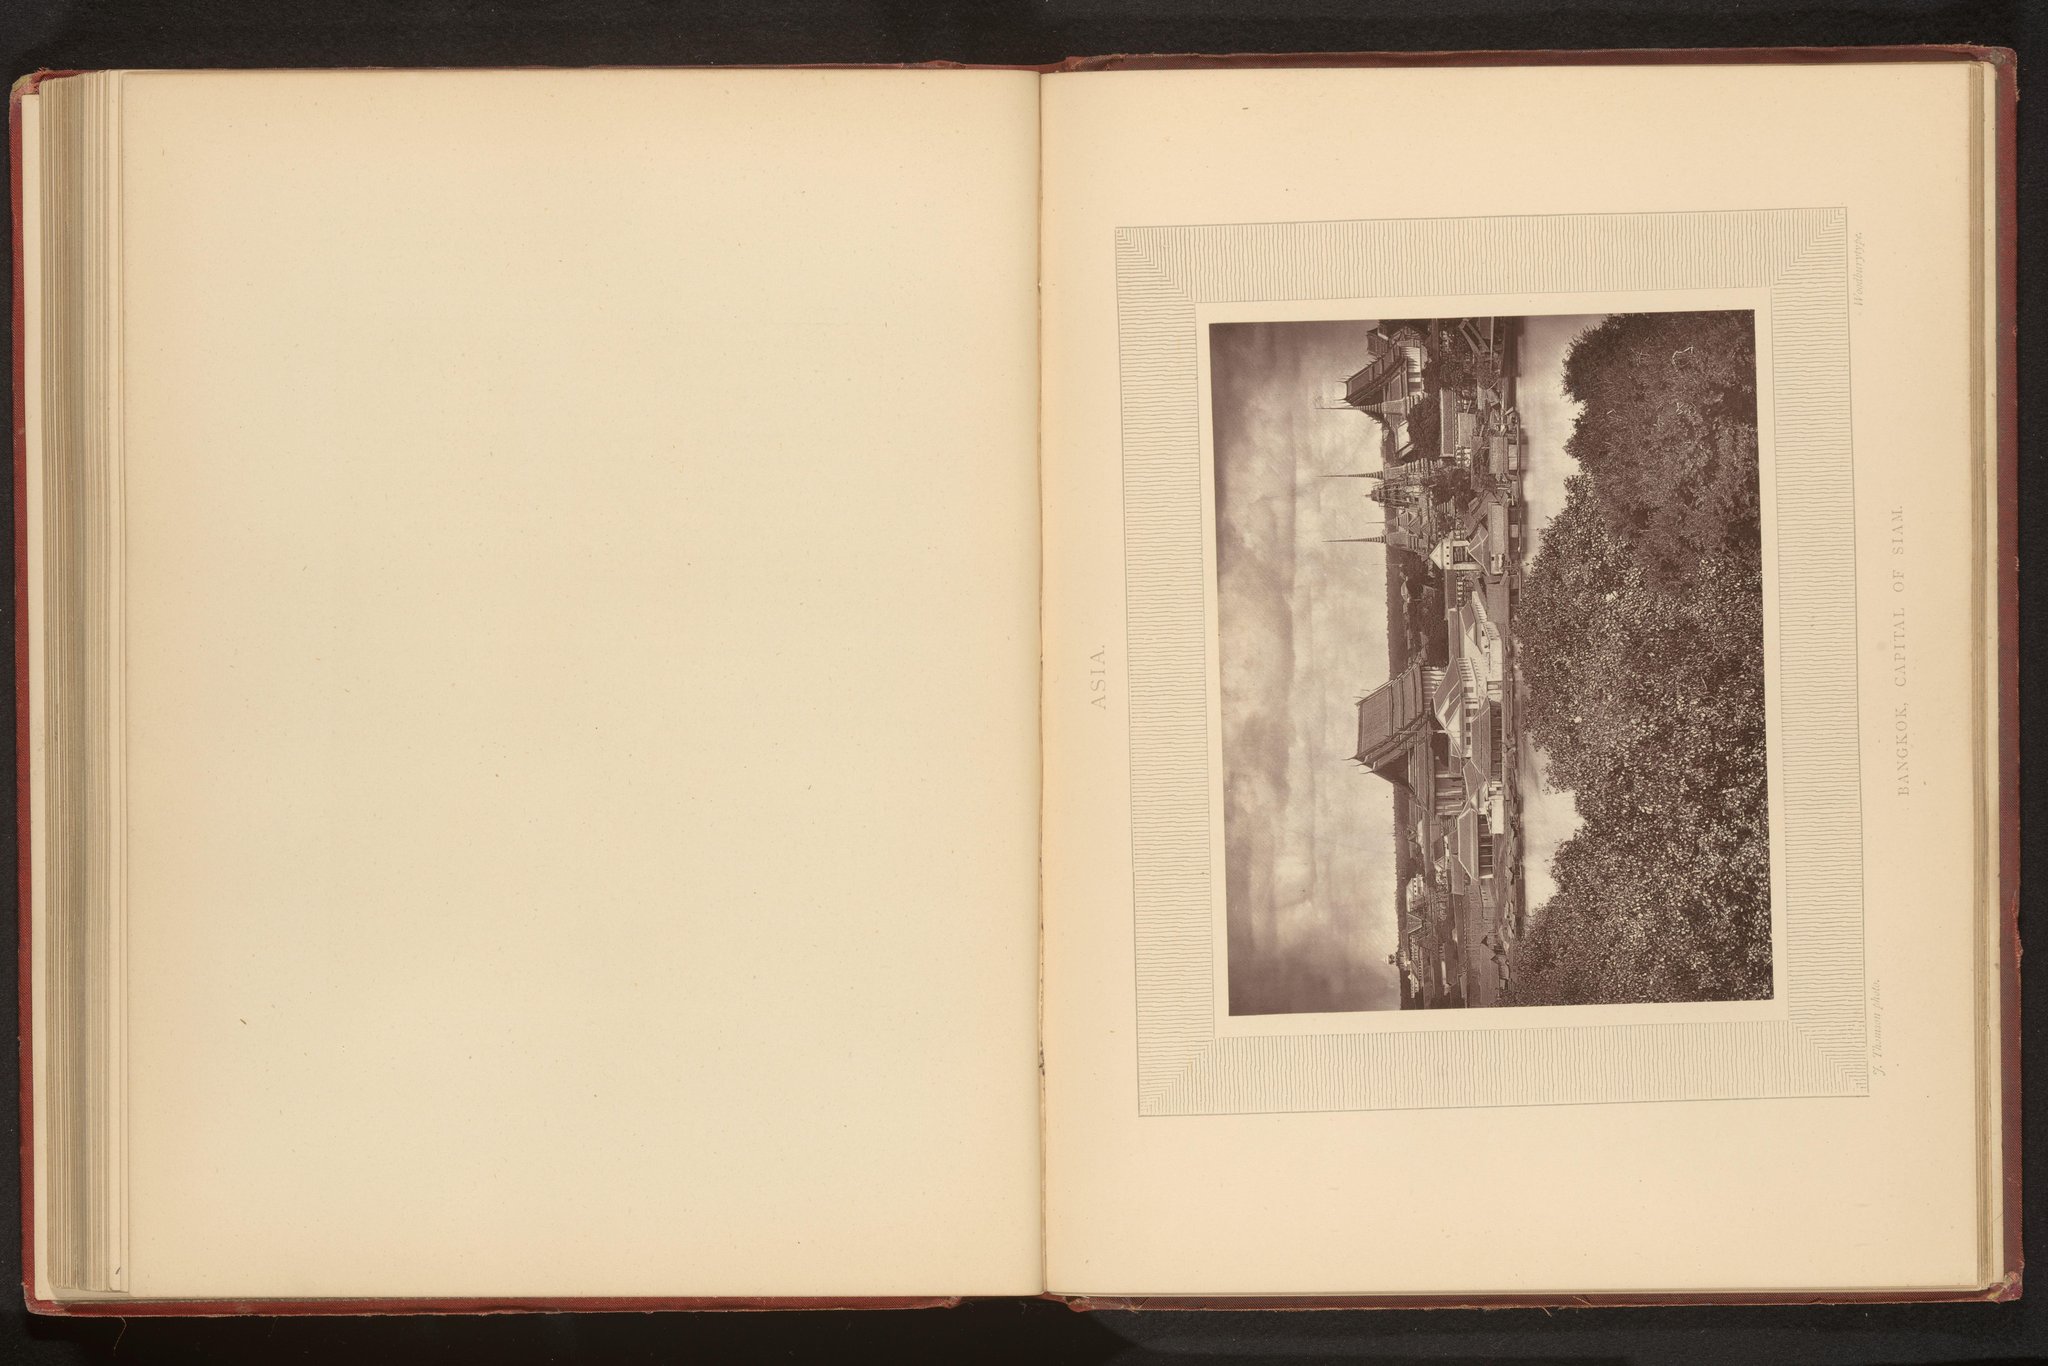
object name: photomechanical print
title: Bangkok, capital of Siam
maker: john thomson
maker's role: fotograaf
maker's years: 1837-1921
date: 1870-1875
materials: cardboard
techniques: woodburytype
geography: alhambra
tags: temple, shrine ~ hinduism, buddhism, jainism, city-view in general; 'veduta'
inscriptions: inscription: ‘Asia’